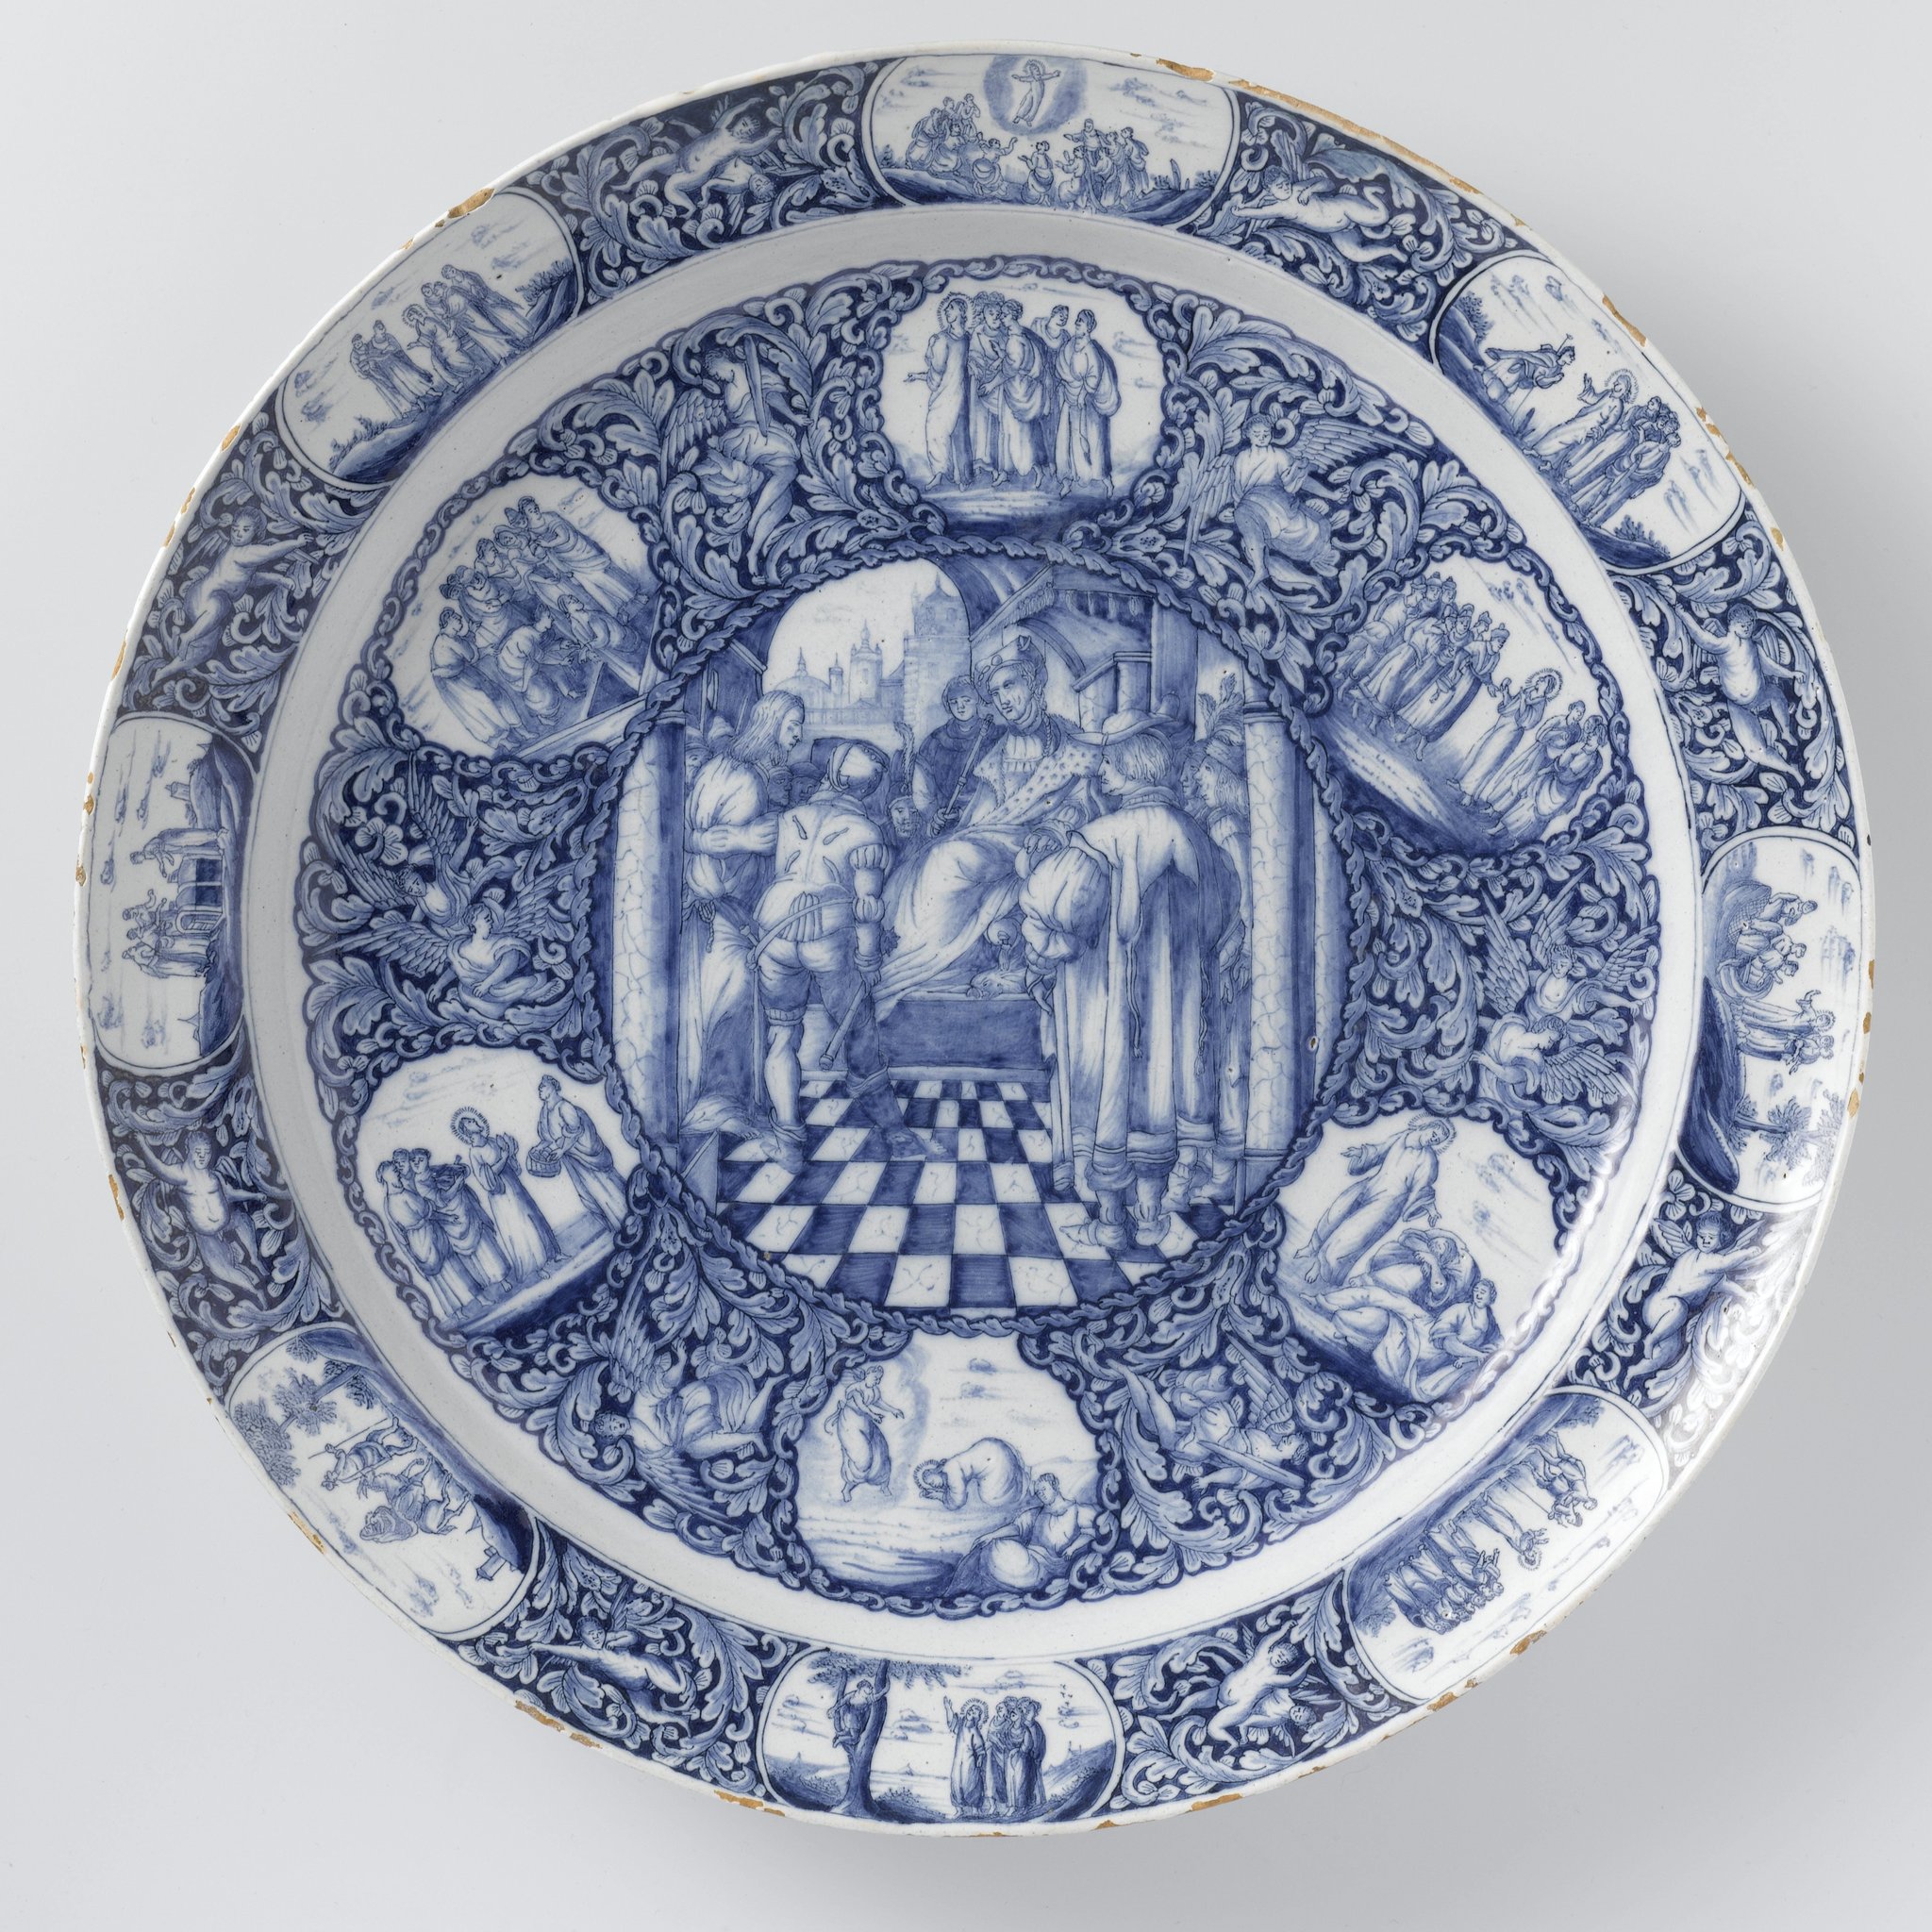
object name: platter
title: Schotel, beschilderd met vijftien scènes uit het leven van Christus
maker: johannes verhagen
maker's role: plateelbakker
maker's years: -1739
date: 1729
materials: earthenware, glaze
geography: delft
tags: trial of christ, christ before his judges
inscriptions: date: ‘1729’, signature: ‘I.V.H.’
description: Verhagen had van ca. 1720 t/m 1729 een huisoven waar hij poppengoed, maar ook enkele grotere stukken maakte. In 1729 kocht hij De Paauw, die hij tot zijn dood in 1739 bezat. Zijn weduwe zette de fabriek nog een jaar voort, voor ze deze aan Jacobus de Milde verkocht.